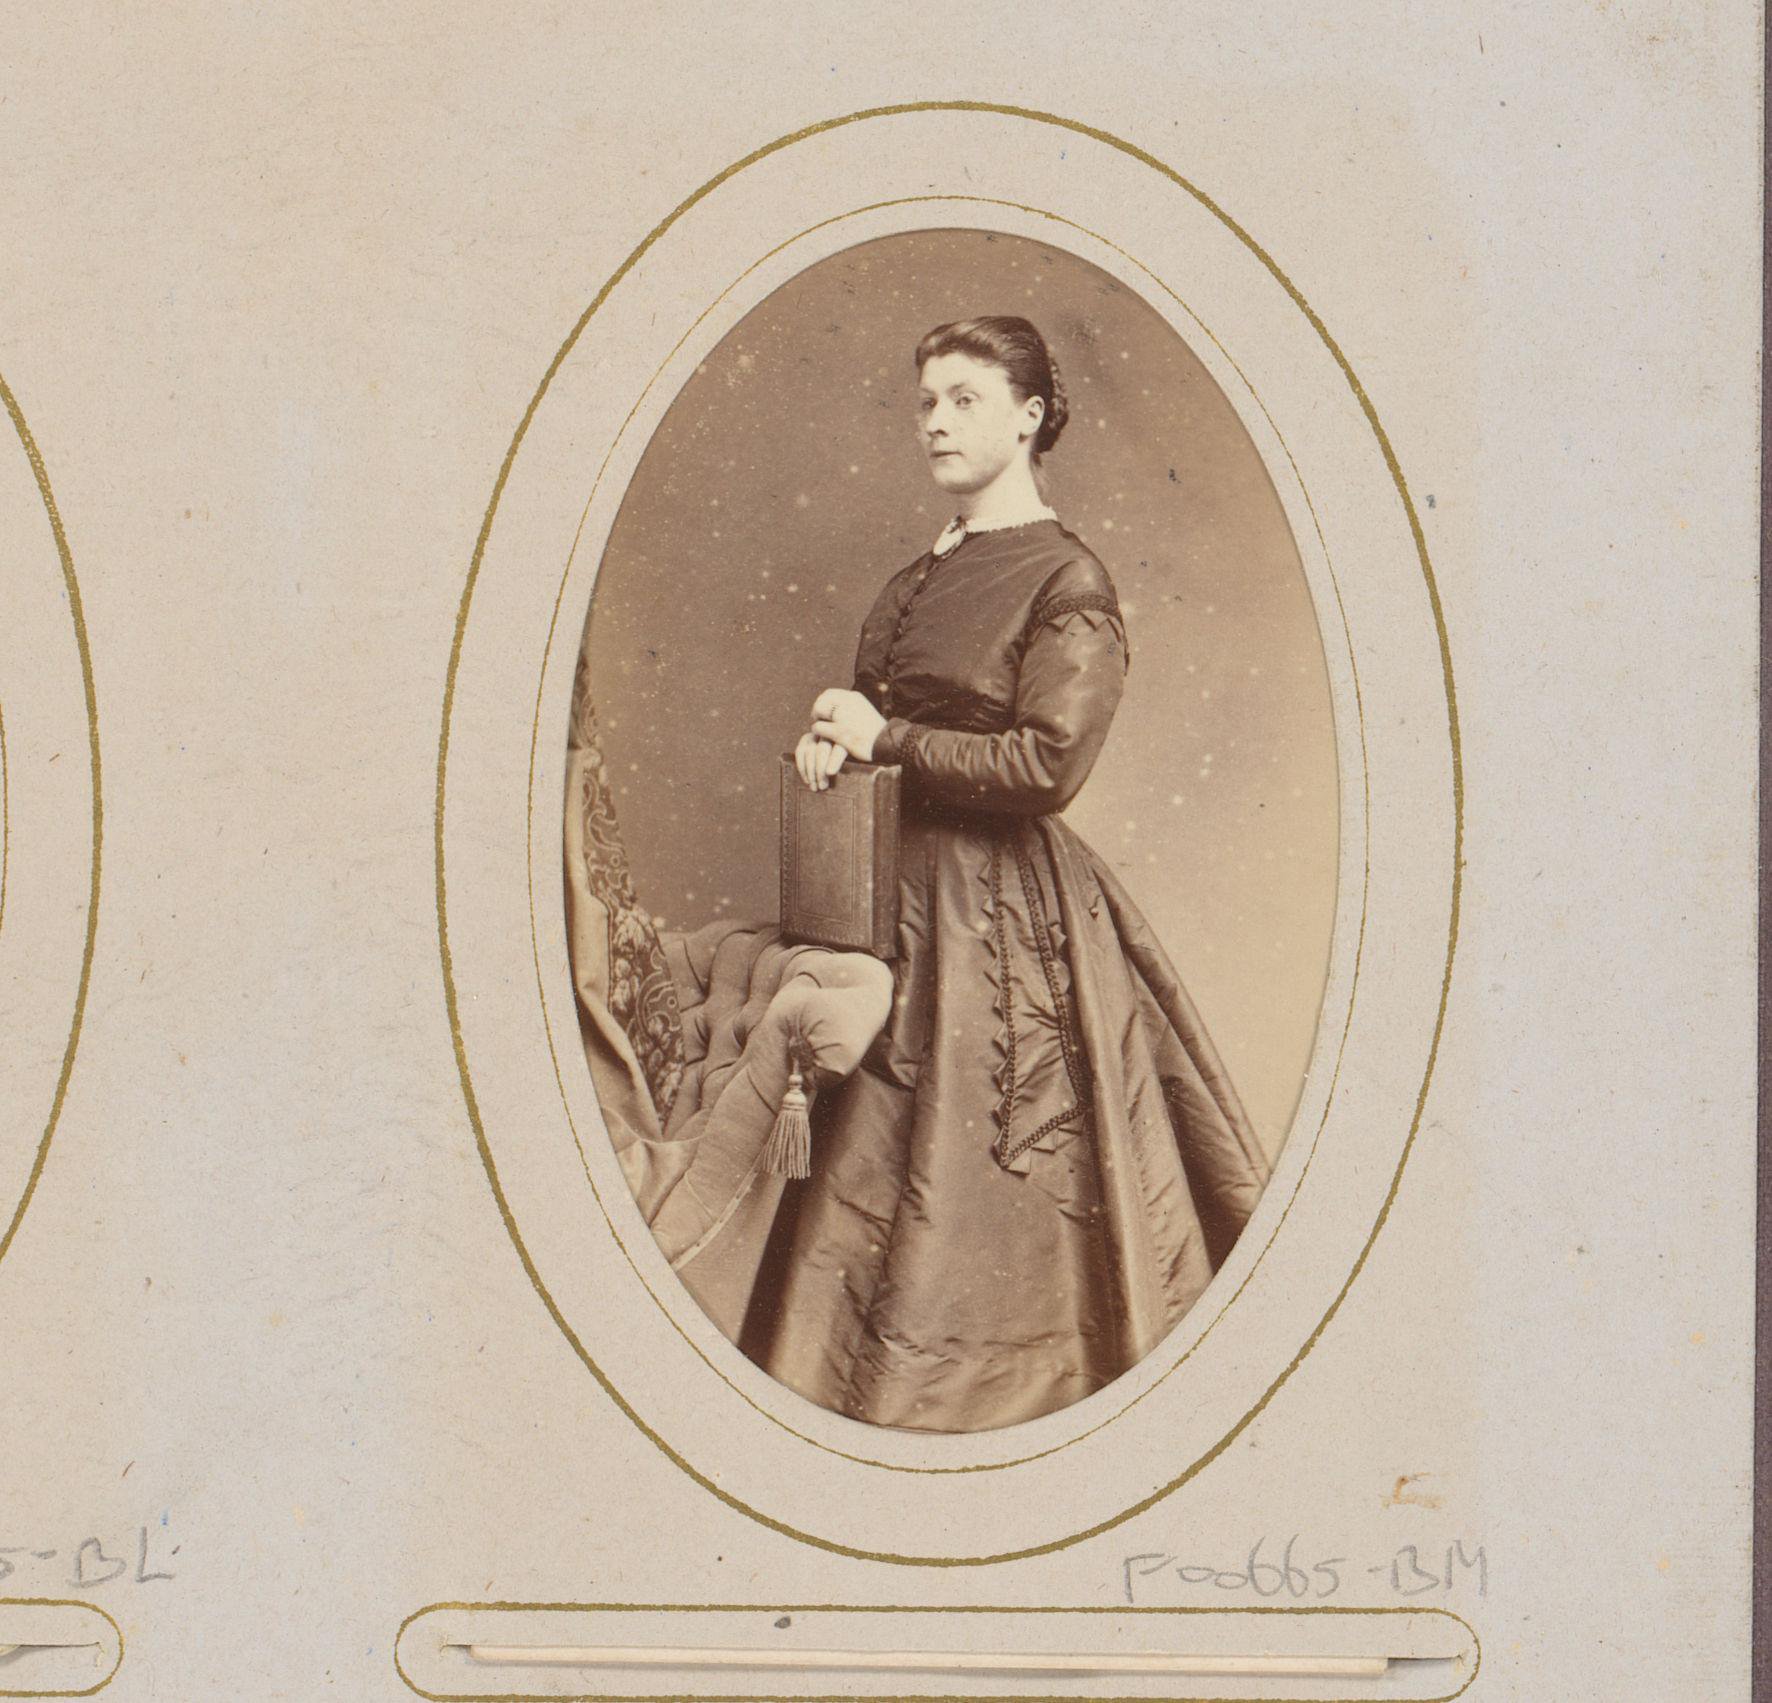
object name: album leaf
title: Portret van een vrouw met boek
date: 1865-1890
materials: cardboard, photographic support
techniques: albumen print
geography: amsterdam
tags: historical persons - bb - woman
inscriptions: inscription: ‘Photogr Atelier/ Wegner & Mottu/ Kalverstraat/ Over den Heyligenweg D.26/ Amsterdam’